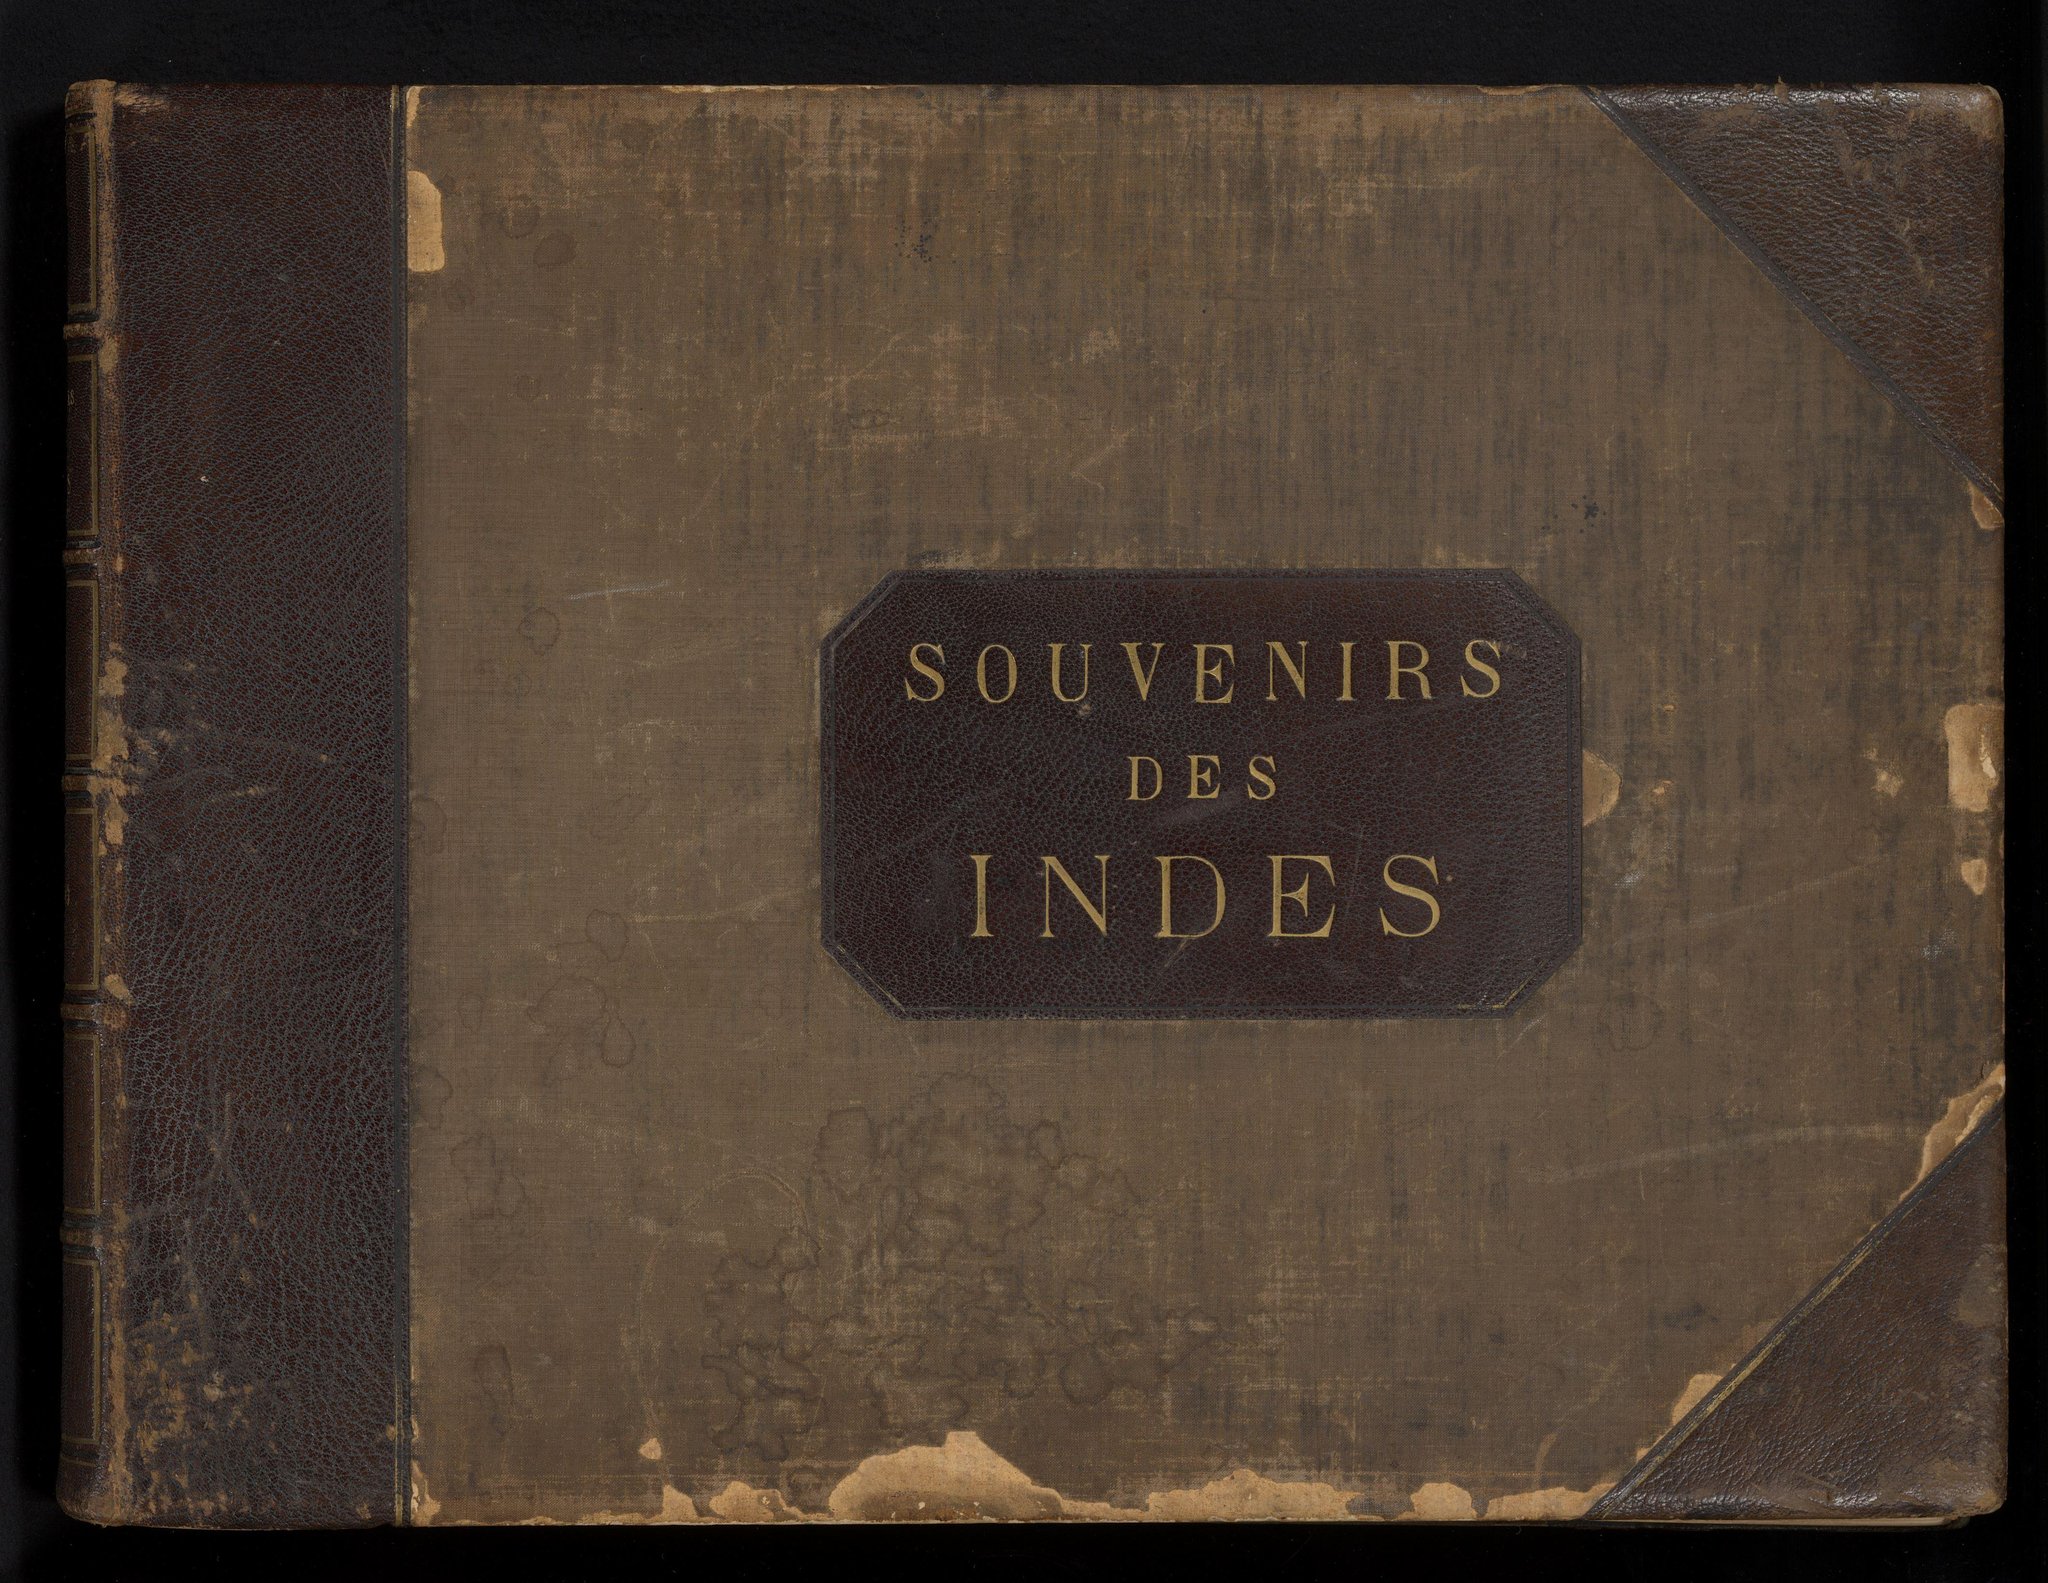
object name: scrapbook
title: Souvenirs des Indes 1882-83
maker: Anonymous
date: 1882-1883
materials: cardboard, leather, linen, paper, photographic support, wood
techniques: albumen print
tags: travelling; tourism, singapore, dutch east indies, the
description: Fotoalbum in bruine linnen band met leren rug en hoekstukken. Op het voorplat de titel, op de rug de titel met het jaartal '1882-1883'. Het album bevat 81 foto's die voorzien zijn van Franstalige onderschriften. Het is het fotografisch verslag van een reis naar Nederlands-Indië, Singapore en Brits Ceylon, via Port Said in Egypte en het Suezkanaal. Het zijn opnames van haven-, straat-, stads- en dorpsgezichten en landschappen. Daarnaast studioportretten van lokale bewoners.